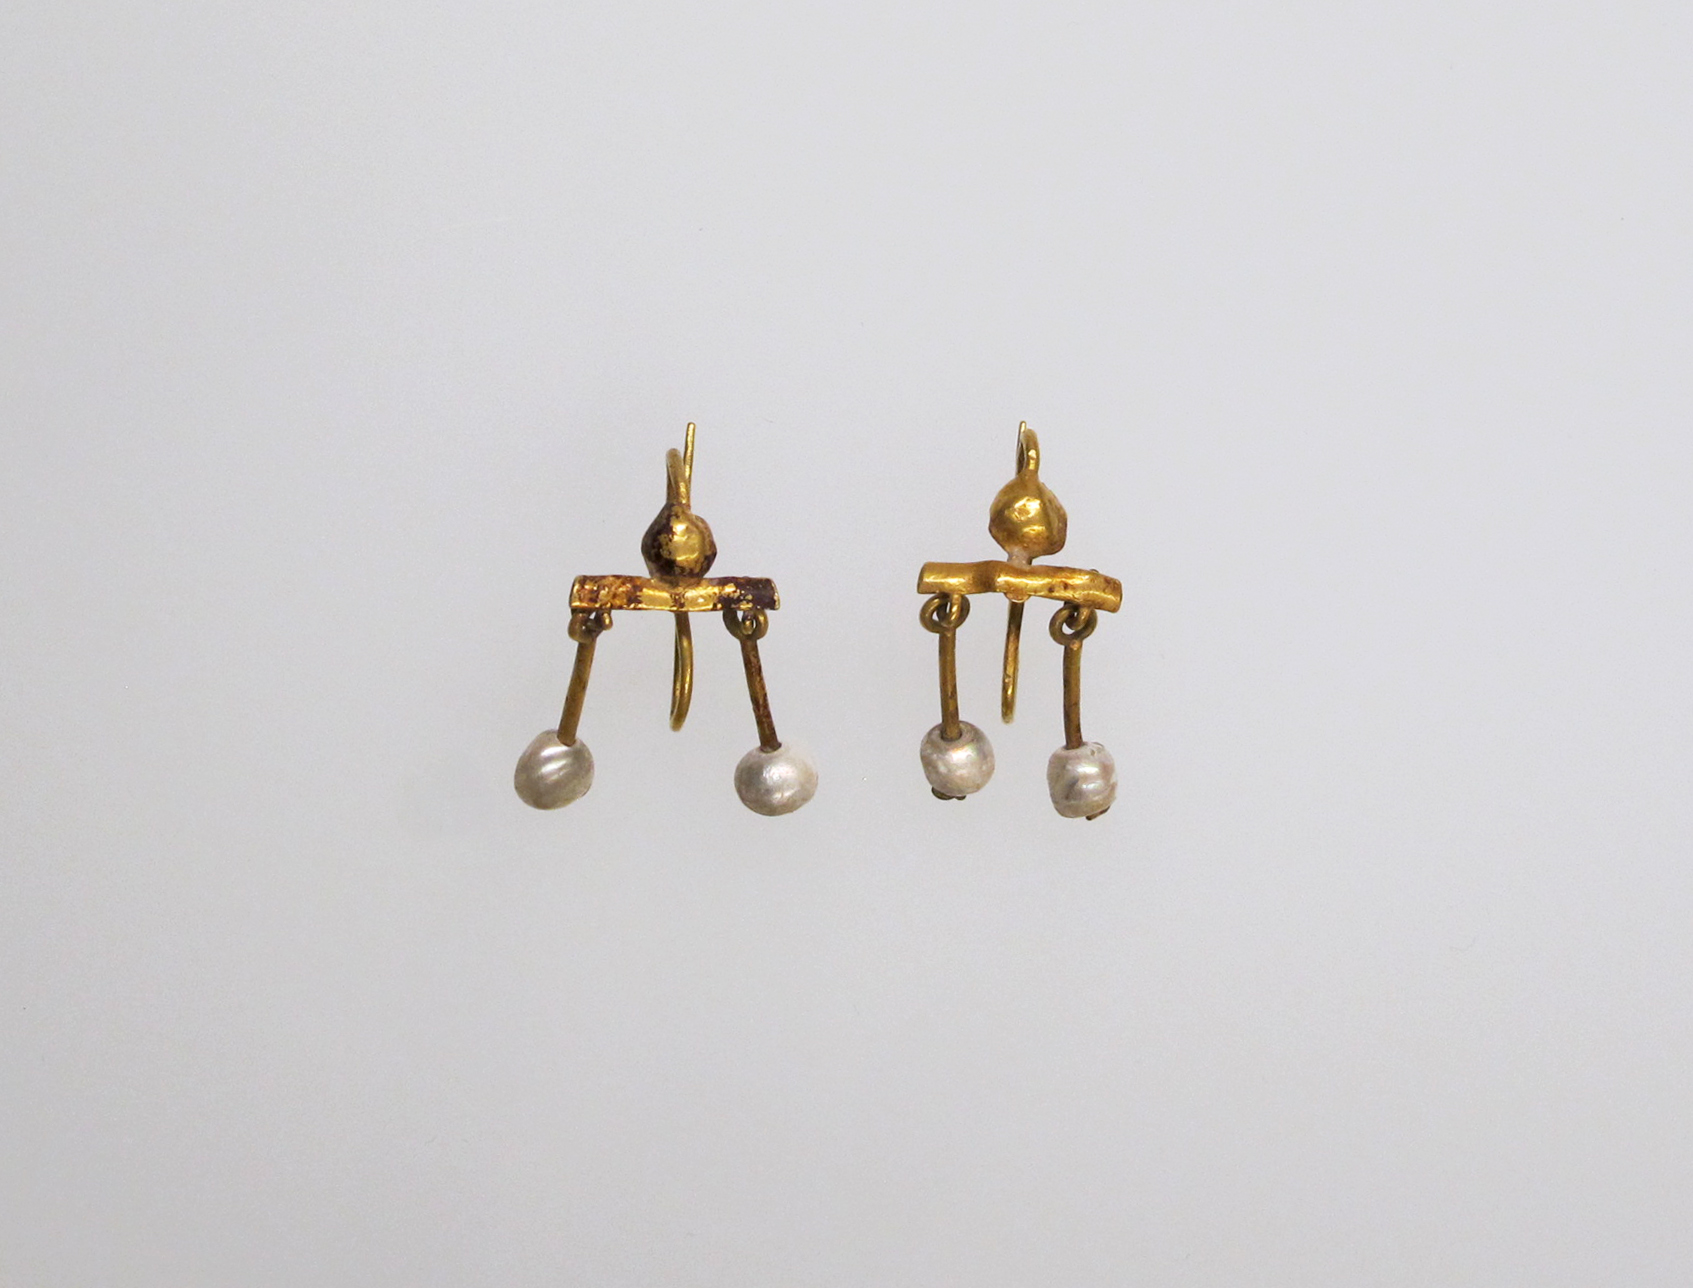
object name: earring with pendant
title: Gold and pearl earring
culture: roman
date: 1-100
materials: gold, pearl